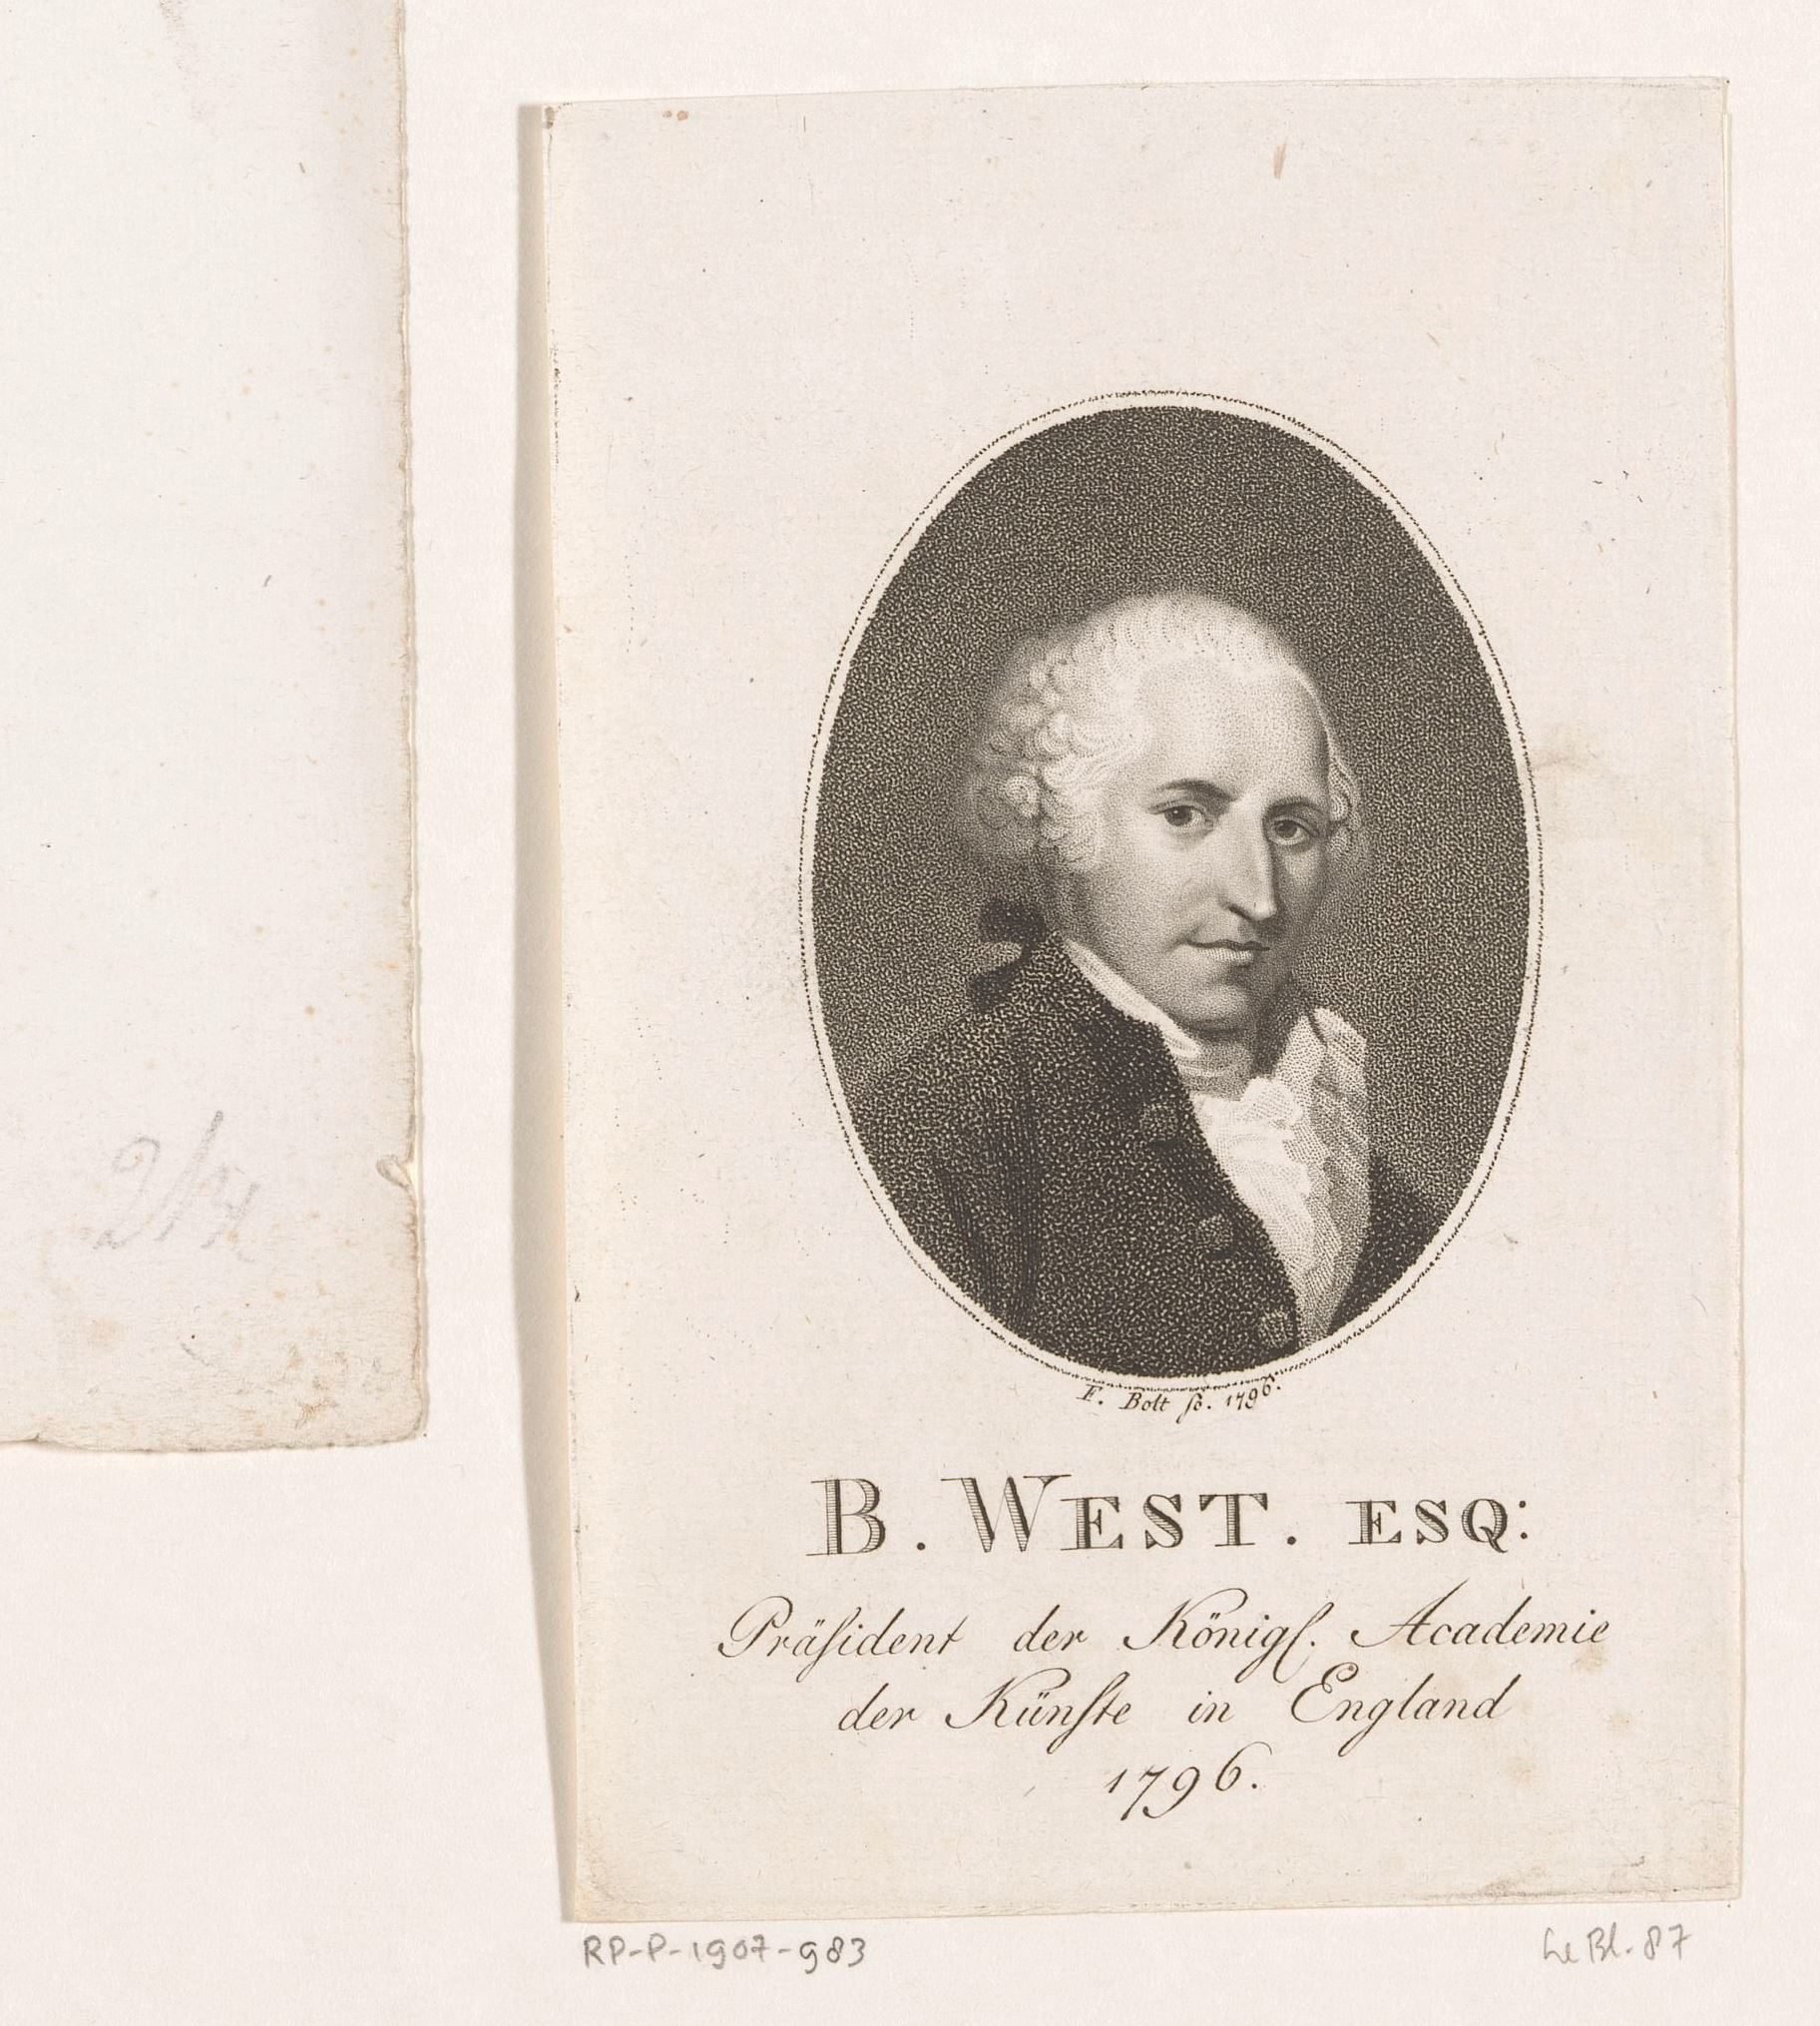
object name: print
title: Portret van Benjamin West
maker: johann friedrich bolt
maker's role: print maker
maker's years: 1769-1836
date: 1796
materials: paper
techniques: stippling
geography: berlin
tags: draughtsman, benjamin west, historical persons, portrait, self-portrait of artist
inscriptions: collector's mark: Lugt 2228